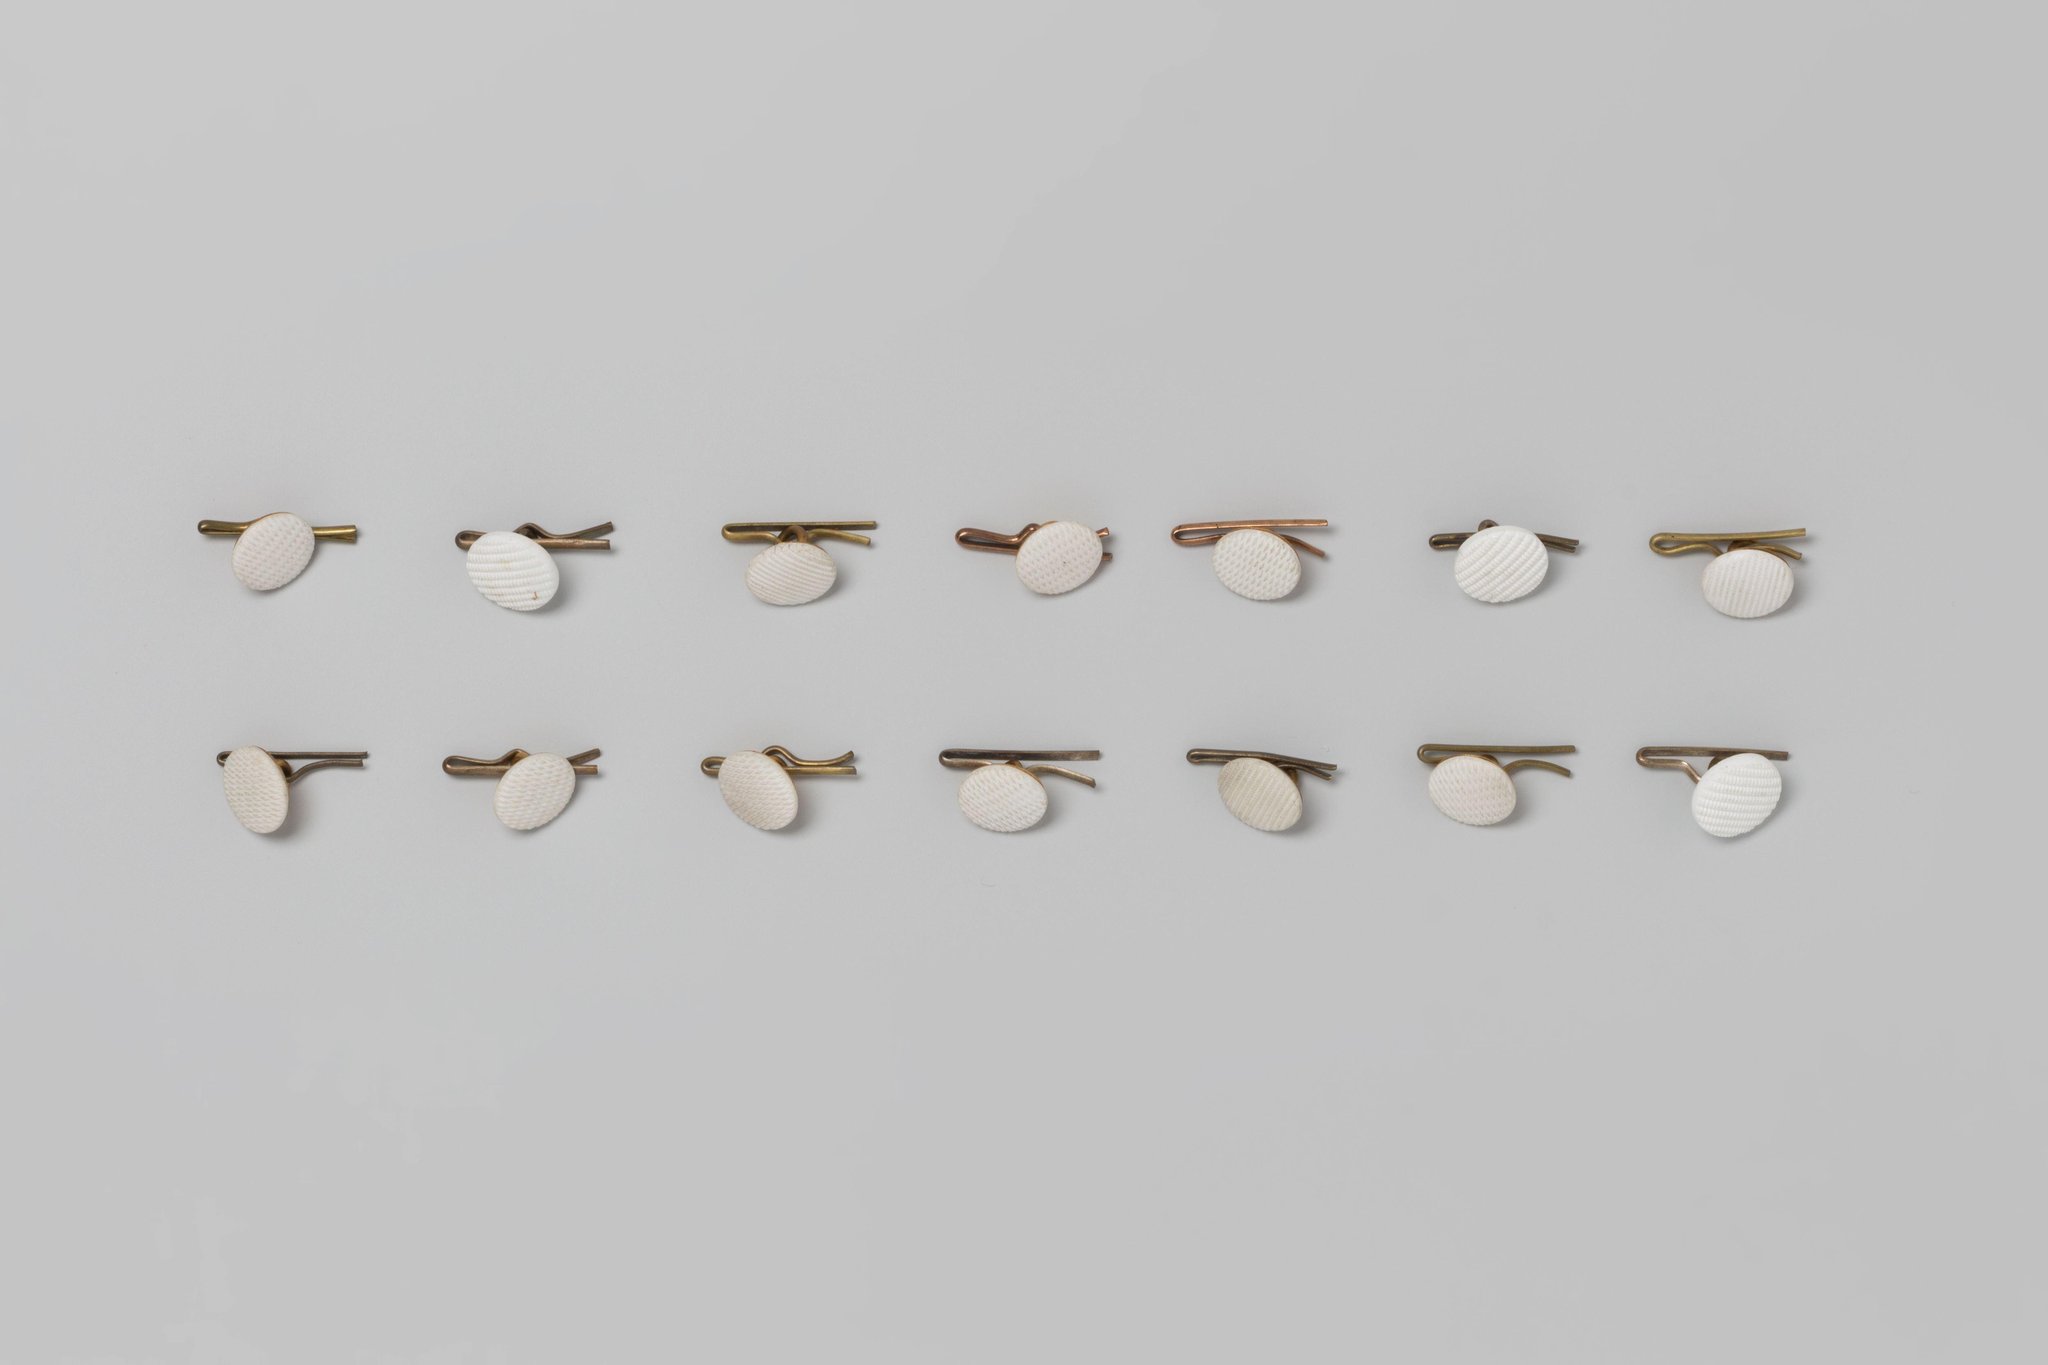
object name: vestknoop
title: Vestknoop van kunststof met reliëf-ribbel, vast oogje en losse tegenklem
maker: Anonymous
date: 1900-1940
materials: copper, plastic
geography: netherlands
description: Vestknoop van kunststof met reliëf-ribbel, vast oogje en losse tegenklem.